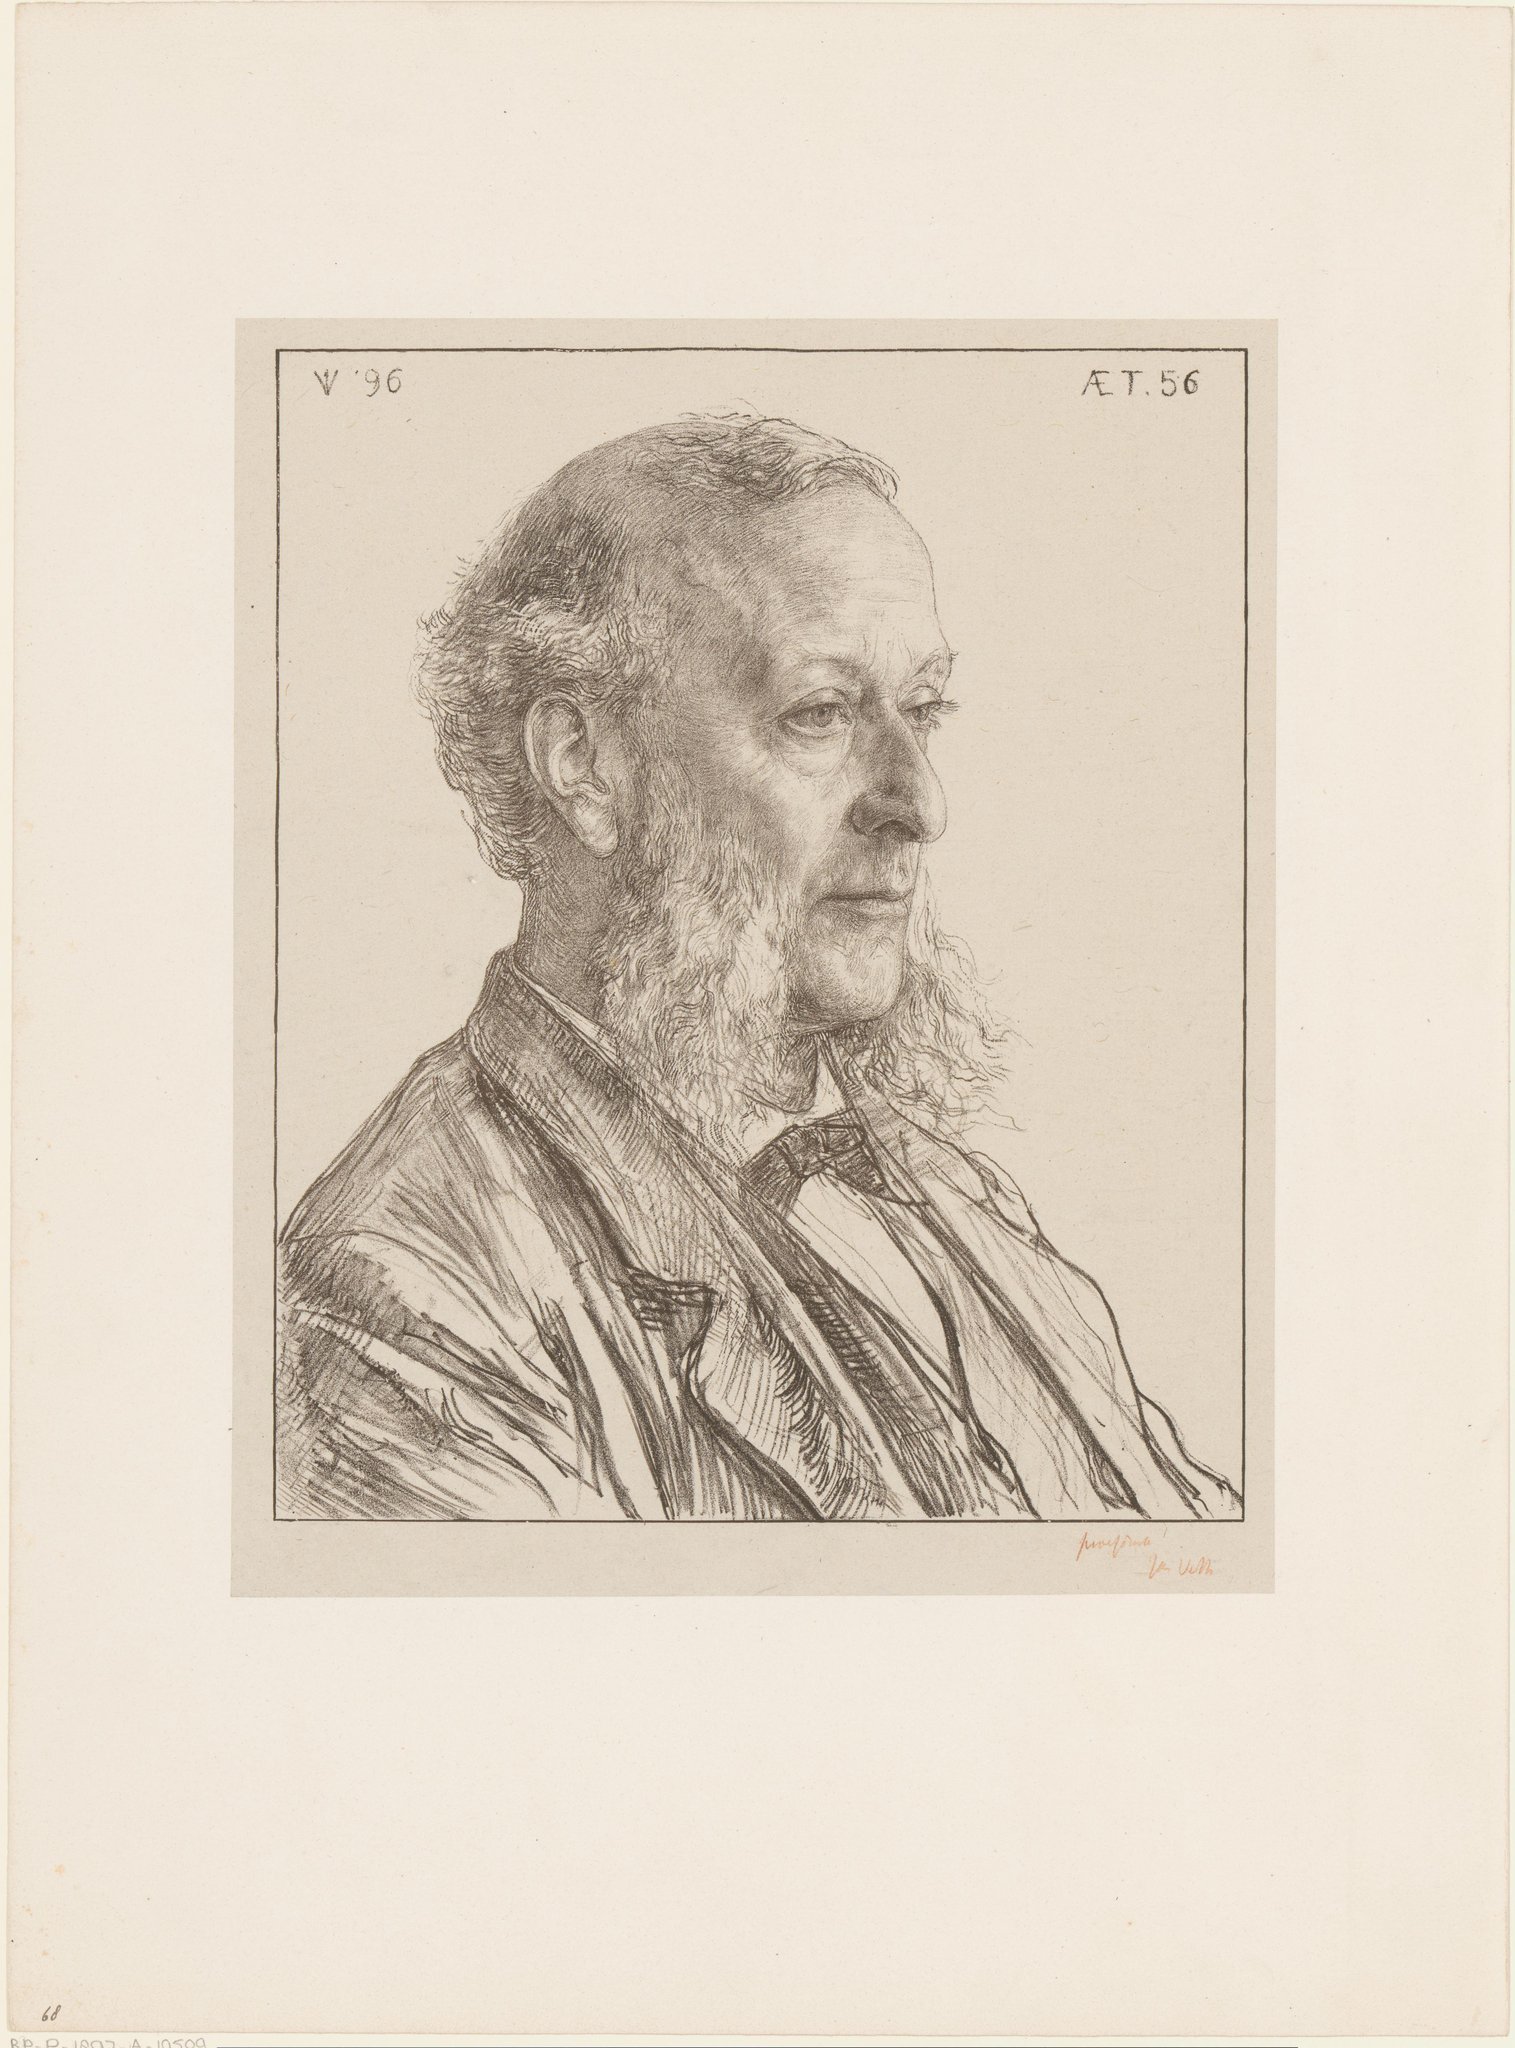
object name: print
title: Portret van Albert Cornelis Vreede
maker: jan veth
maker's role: designer, draughtsman, painter, print maker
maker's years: 1864-1925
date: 1896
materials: paper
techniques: lithograph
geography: netherlands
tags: leiden, albert cornelis vreede, historical persons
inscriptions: inscription: ‘proefdruk / Jan Veth’, collector's mark: Lugt 2228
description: Gereproduceerd in de Leidsche Studentenalmanak 1897.